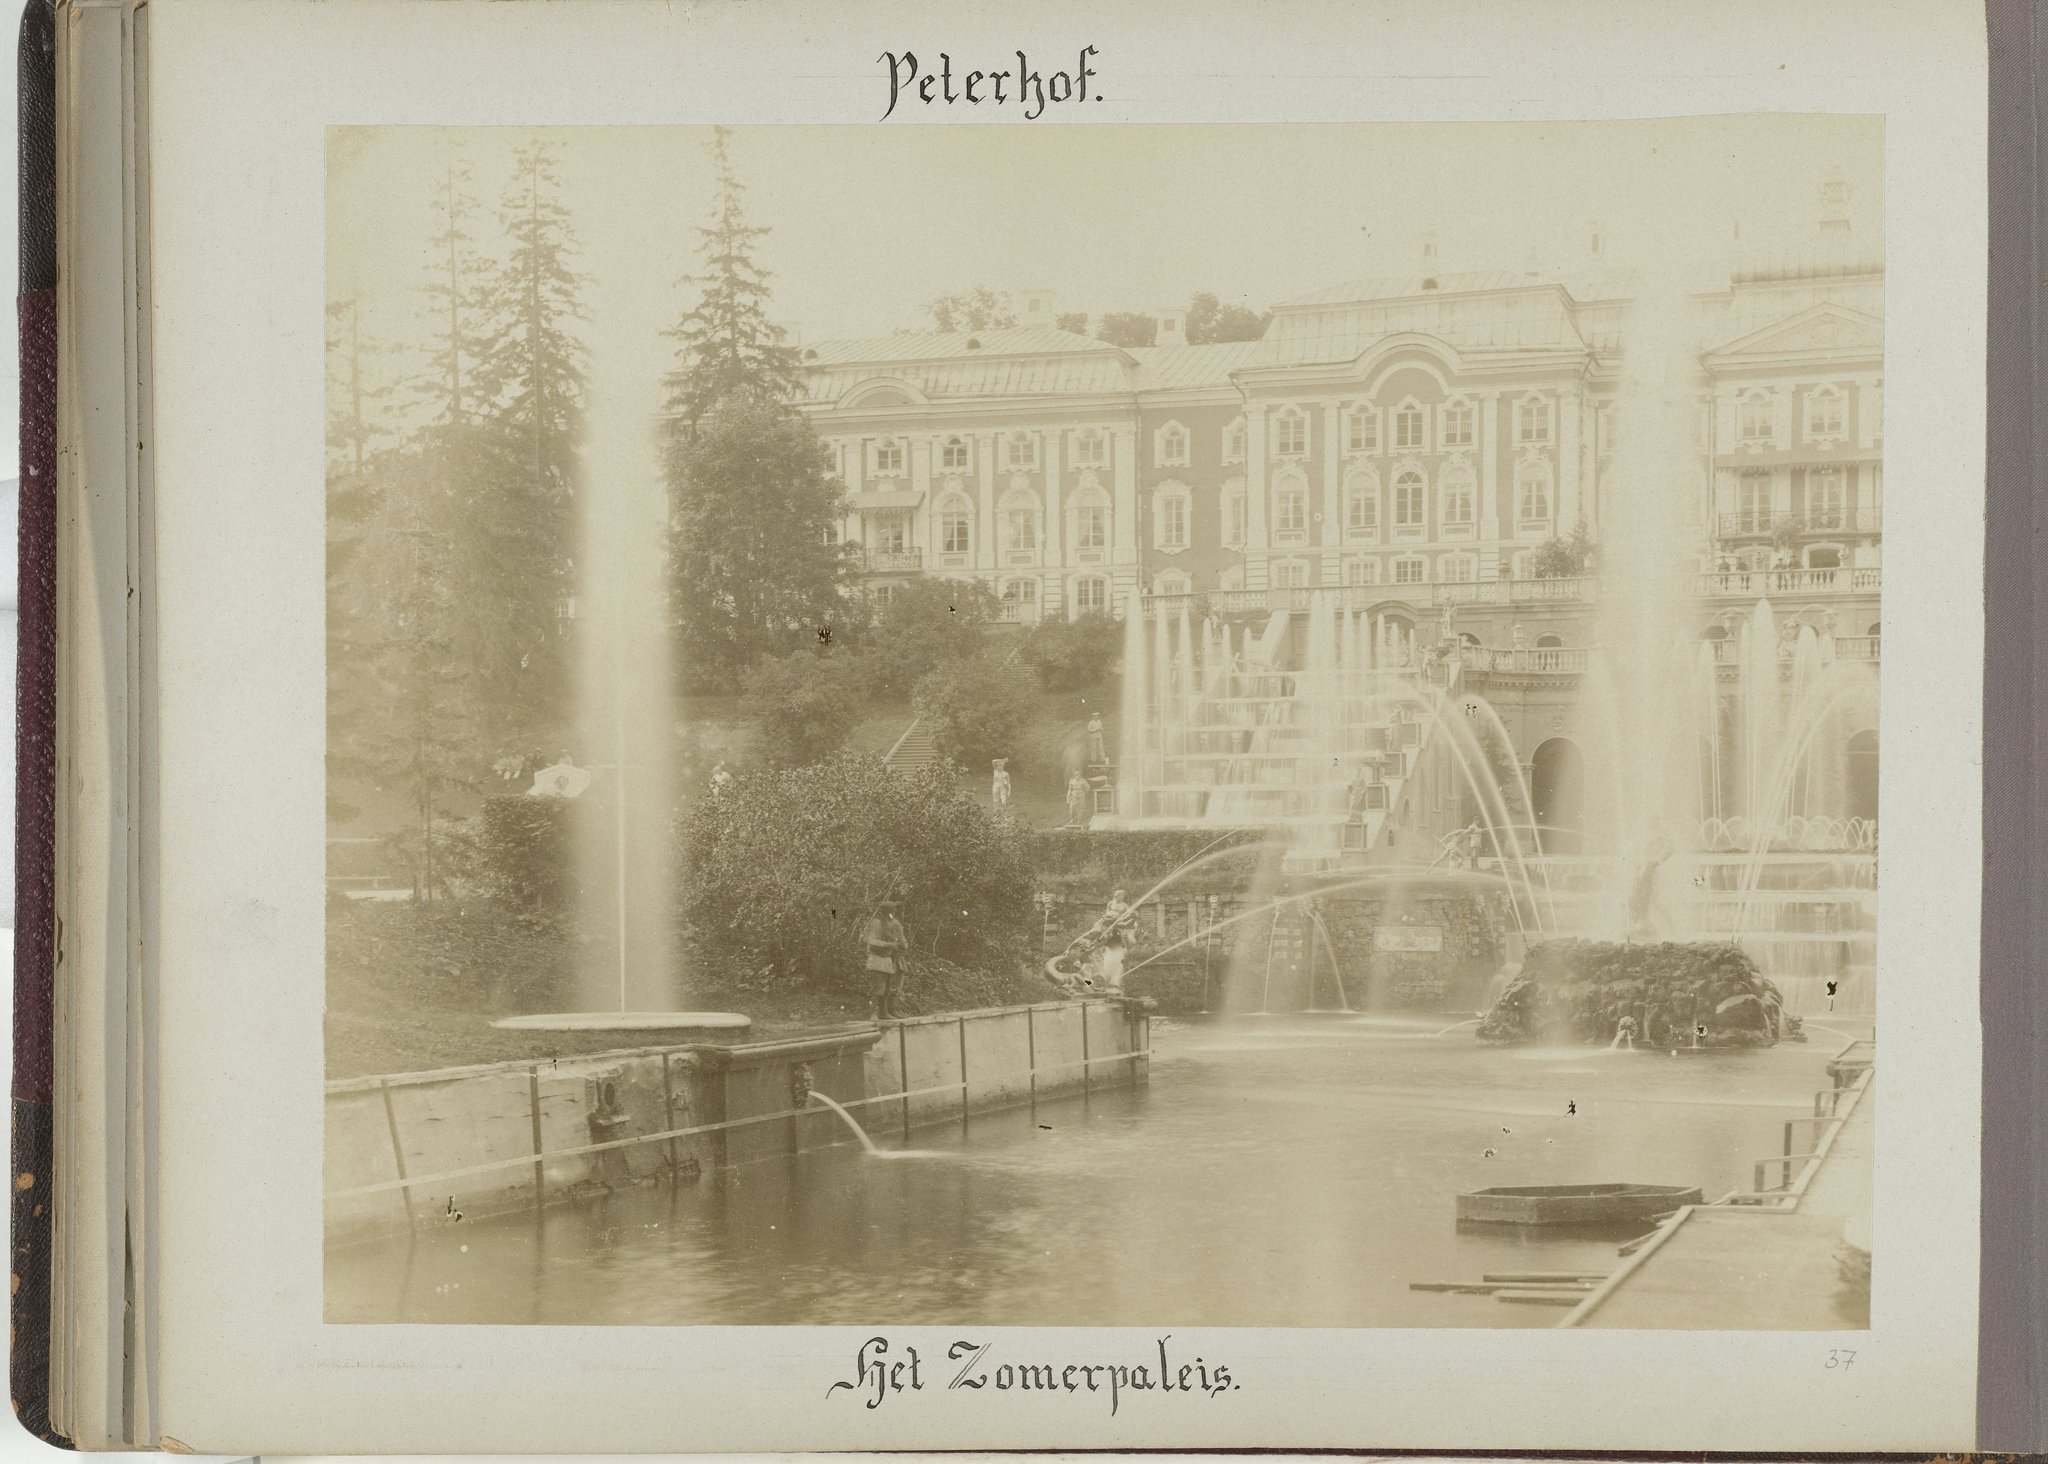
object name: photograph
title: Het zomerpaleis en het Peterhof in de omgeving van Sint-Petersburg.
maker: henry pauw van wieldrecht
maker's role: fotograaf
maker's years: 1863-1912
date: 1898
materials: paper, photographic support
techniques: albumen print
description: Het zomerpaleis met de tuin in de omgeving van Sint-Petersburg. Het paleis is gebouwd in opdracht van Peter de Grote en ontworpen door Domenico Trezzini.